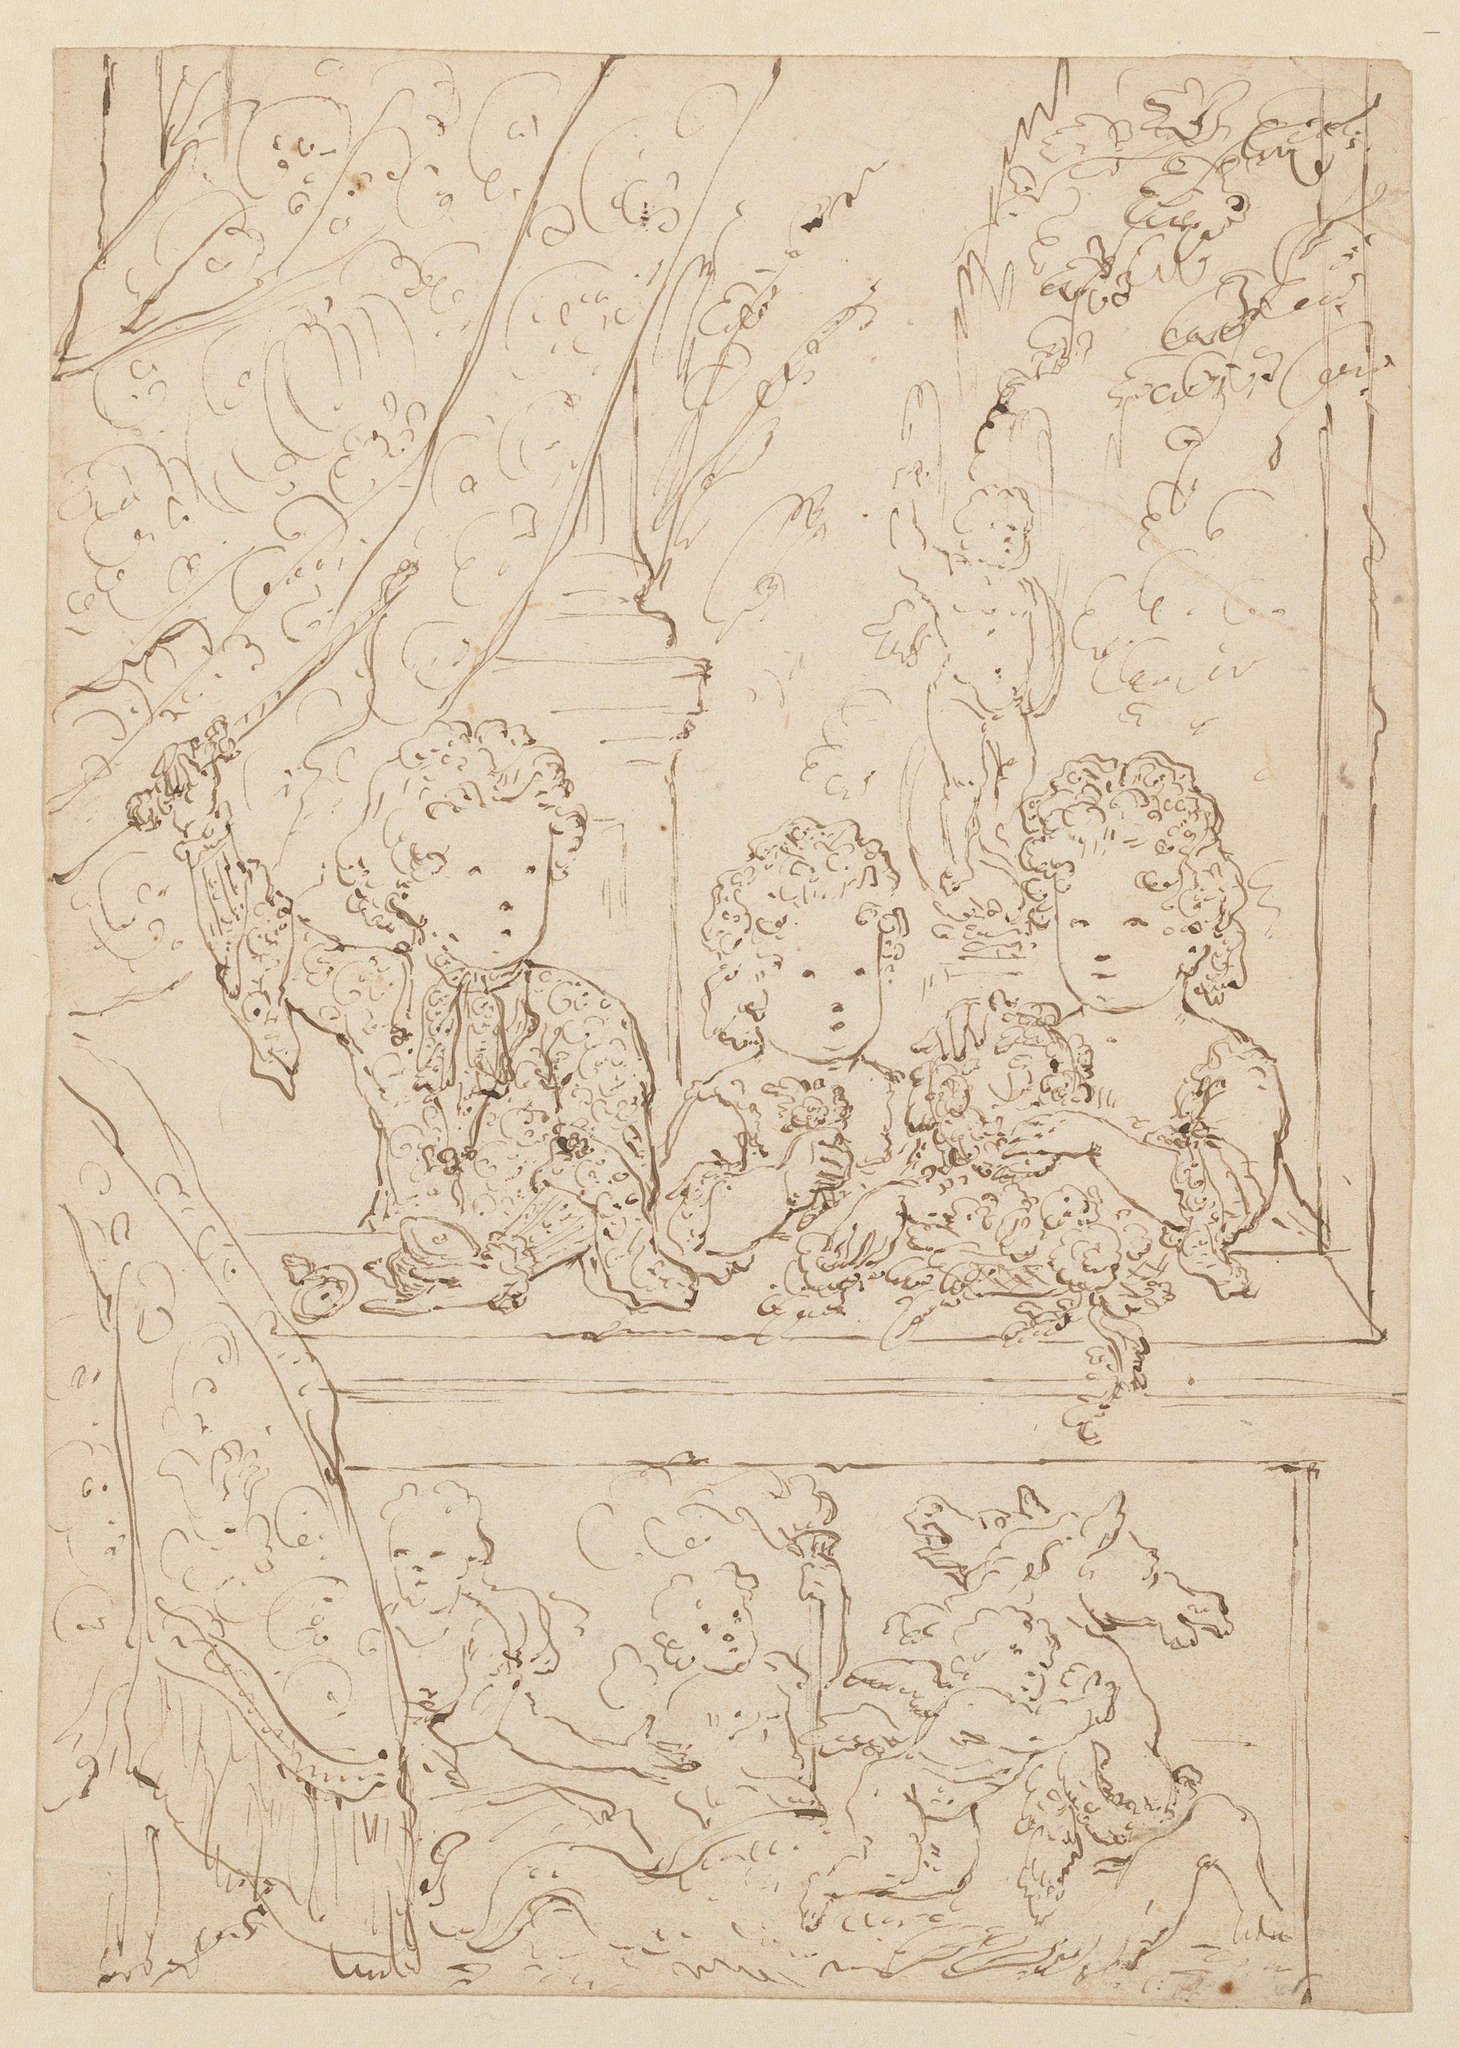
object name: drawing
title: Portret van drie kinderen achter een vensterbank met reliëf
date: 1649-1723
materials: ink, paper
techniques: pen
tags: flowers, historical persons not known by name - bb - woman, sculpture, child (at home) - aa - girl, child (at home), historical persons not known by name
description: Met links een groot gordijn en op de achtergrond een tuin met standbeeld. Tekening maakt deel uit van een album.